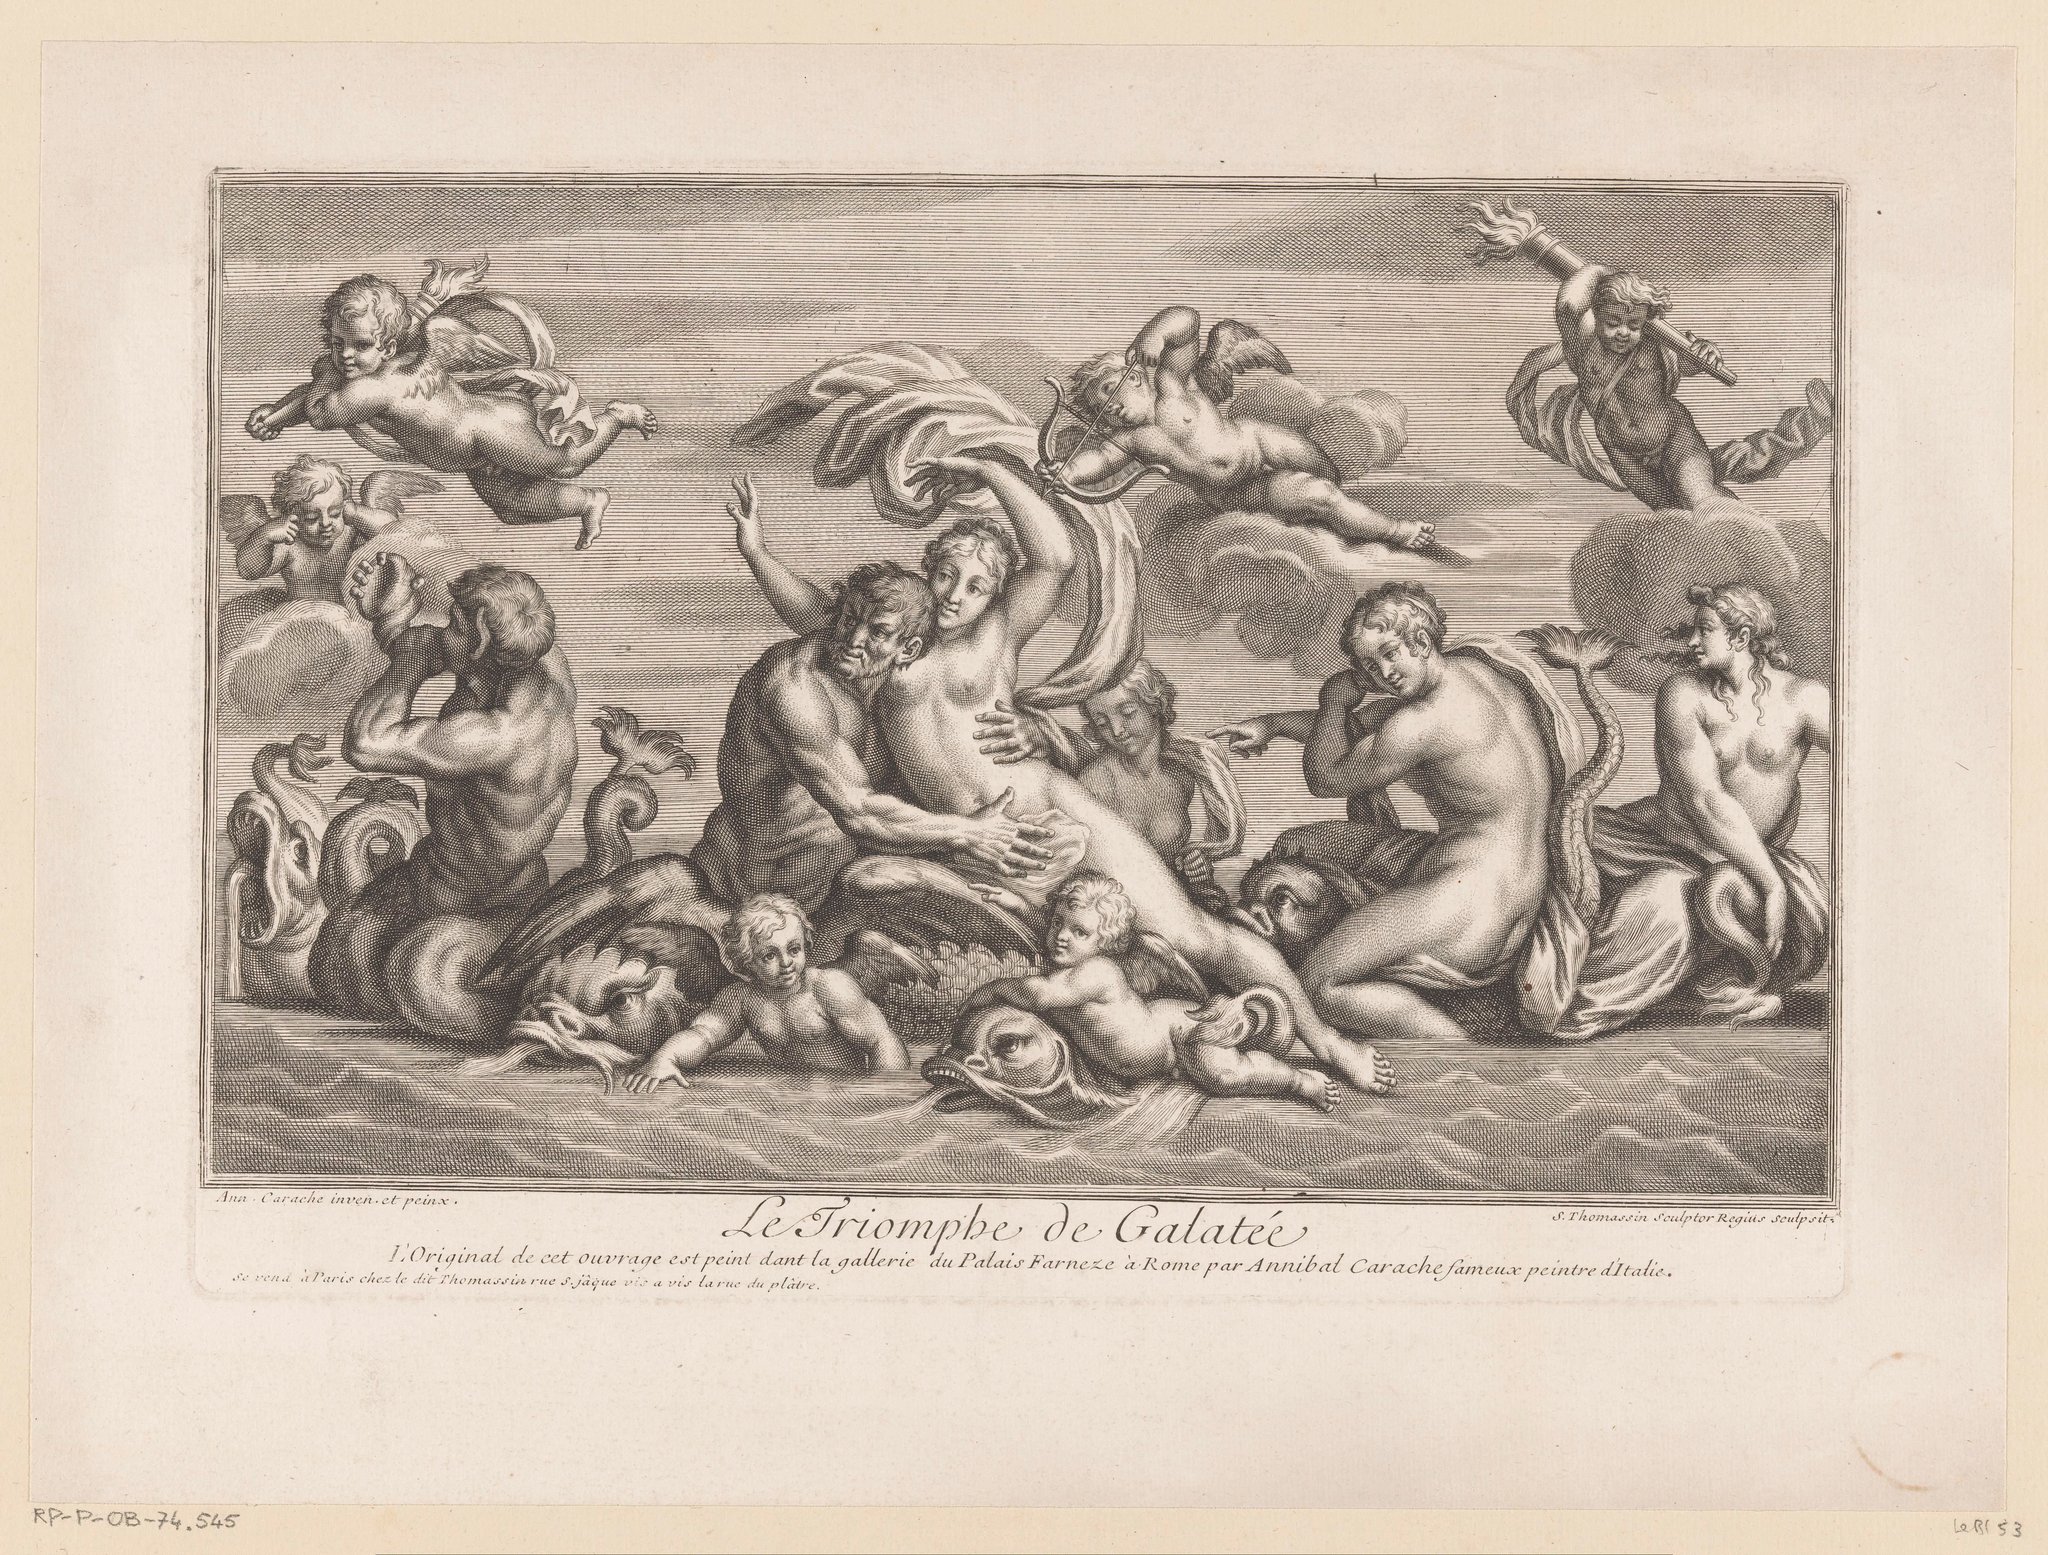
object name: print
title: Triomf van Galatea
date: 1665-1733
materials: paper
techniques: engraving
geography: paris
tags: triton(s), swimming mammals: dolphin, nereids, daughters of nereus; sea-nymphs, triumph of galatea, cupids: 'amores', 'amoretti', 'putti'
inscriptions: collector's mark: Lugt 240